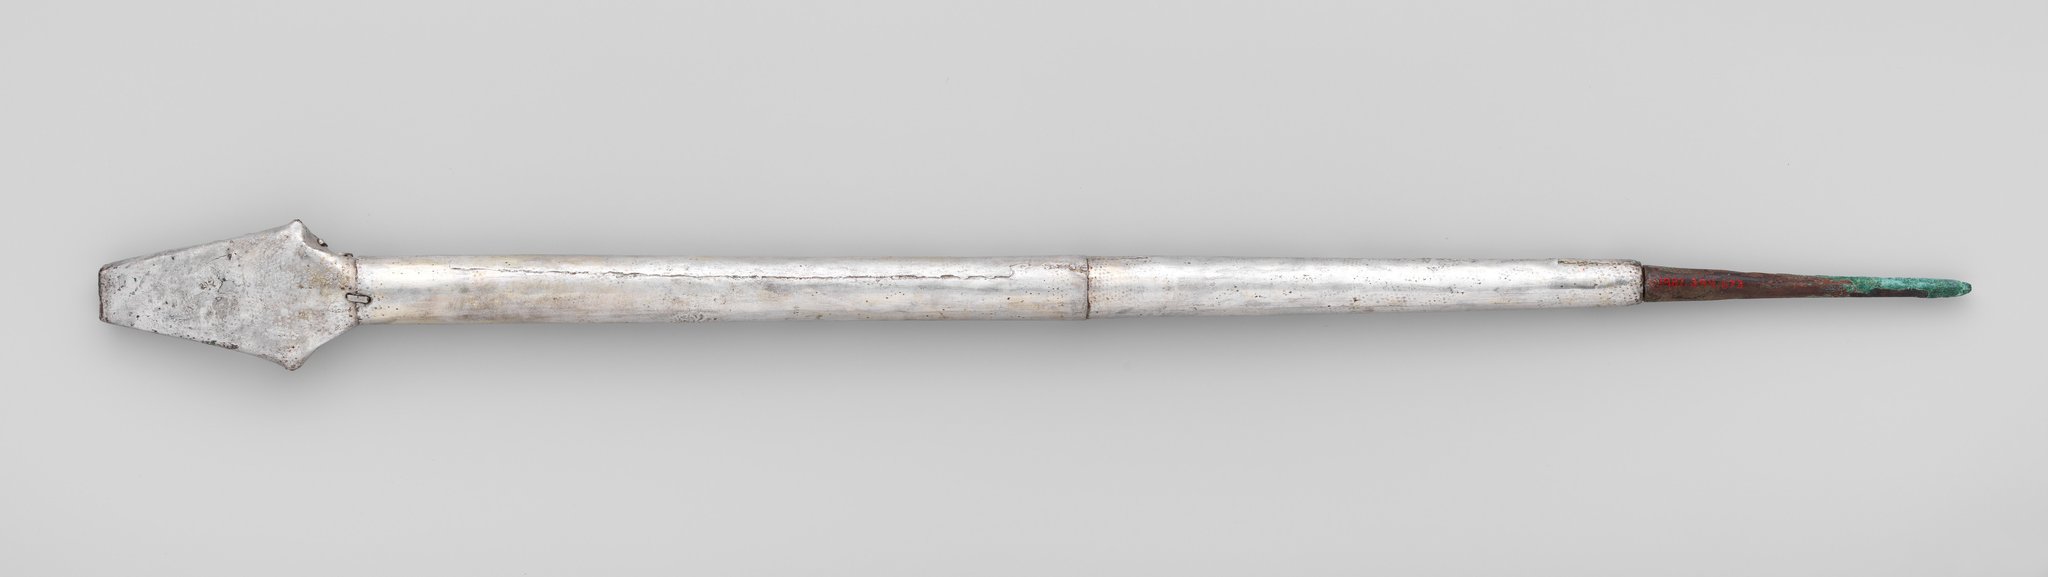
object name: stick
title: Digging stick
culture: chancay or chimú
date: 1101-1500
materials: copper, silver, wood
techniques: hammering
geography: peru